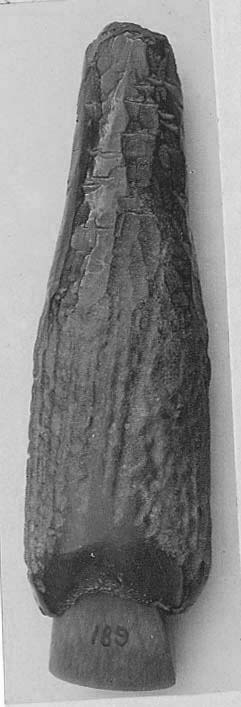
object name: knife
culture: swiss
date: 1902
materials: jade